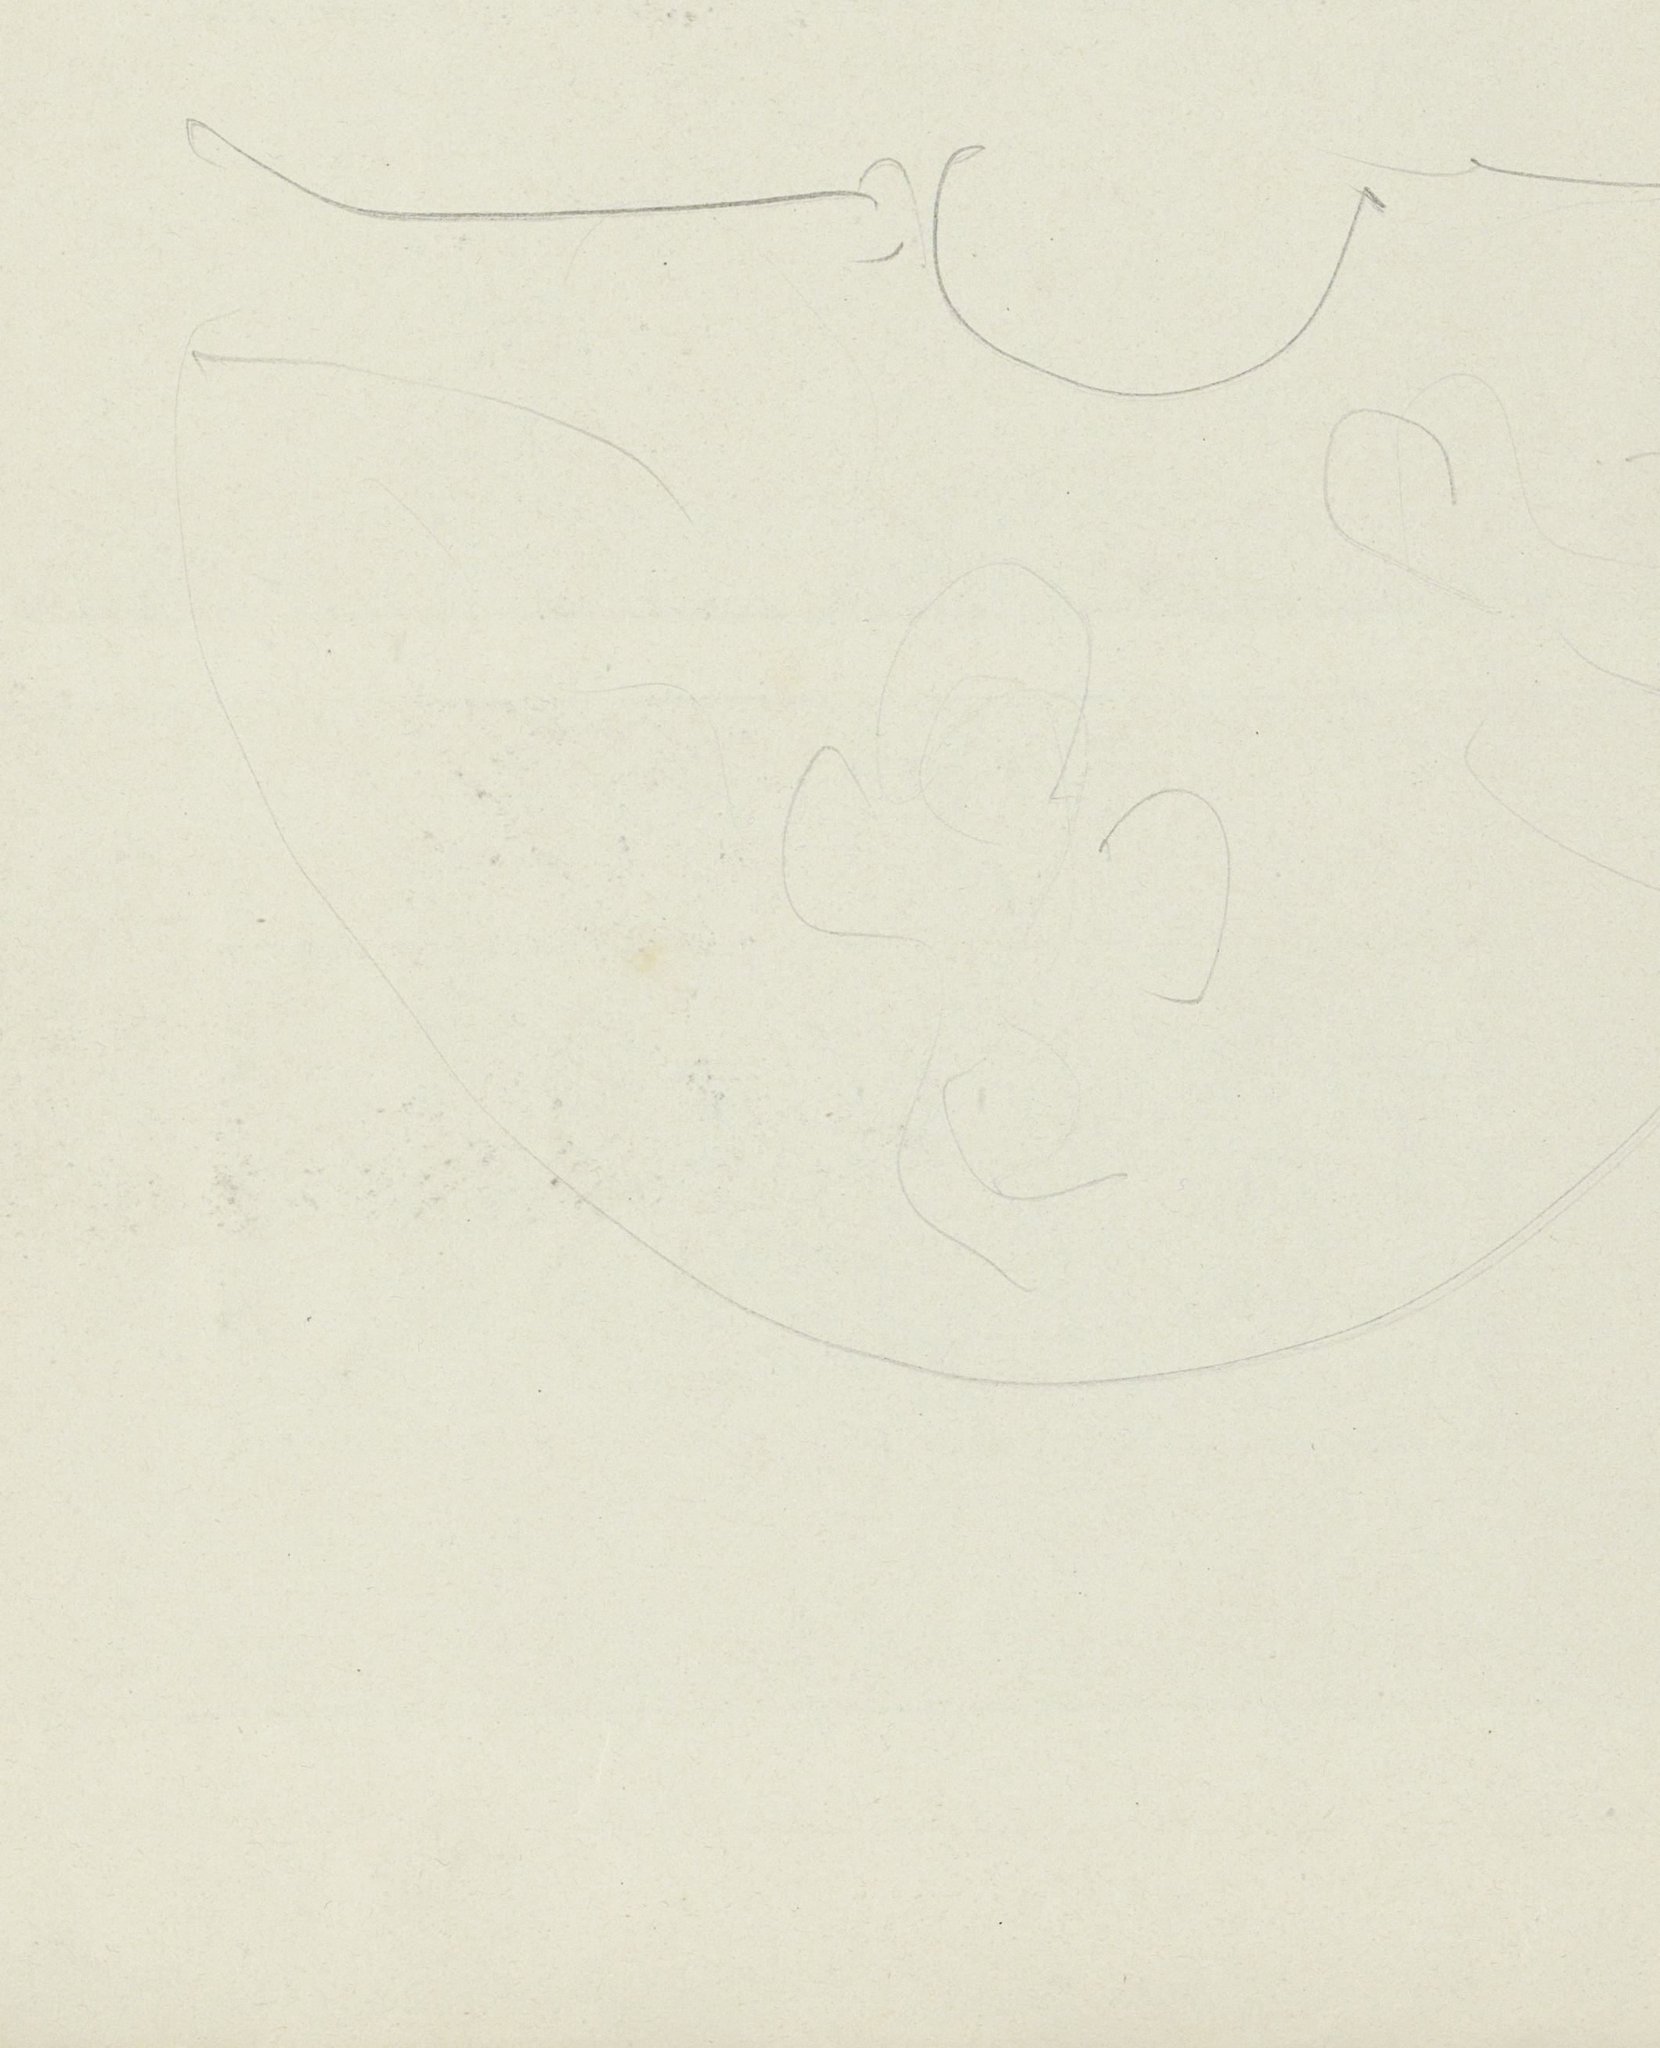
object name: album leaf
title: Studie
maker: gerrit willem dijsselhof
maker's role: designer, draughtsman, print maker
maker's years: 1866-1924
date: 1876-1924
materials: paper, pencil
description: Mogelijk een ornament. Blad 9 verso uit een album met 17 bladen.